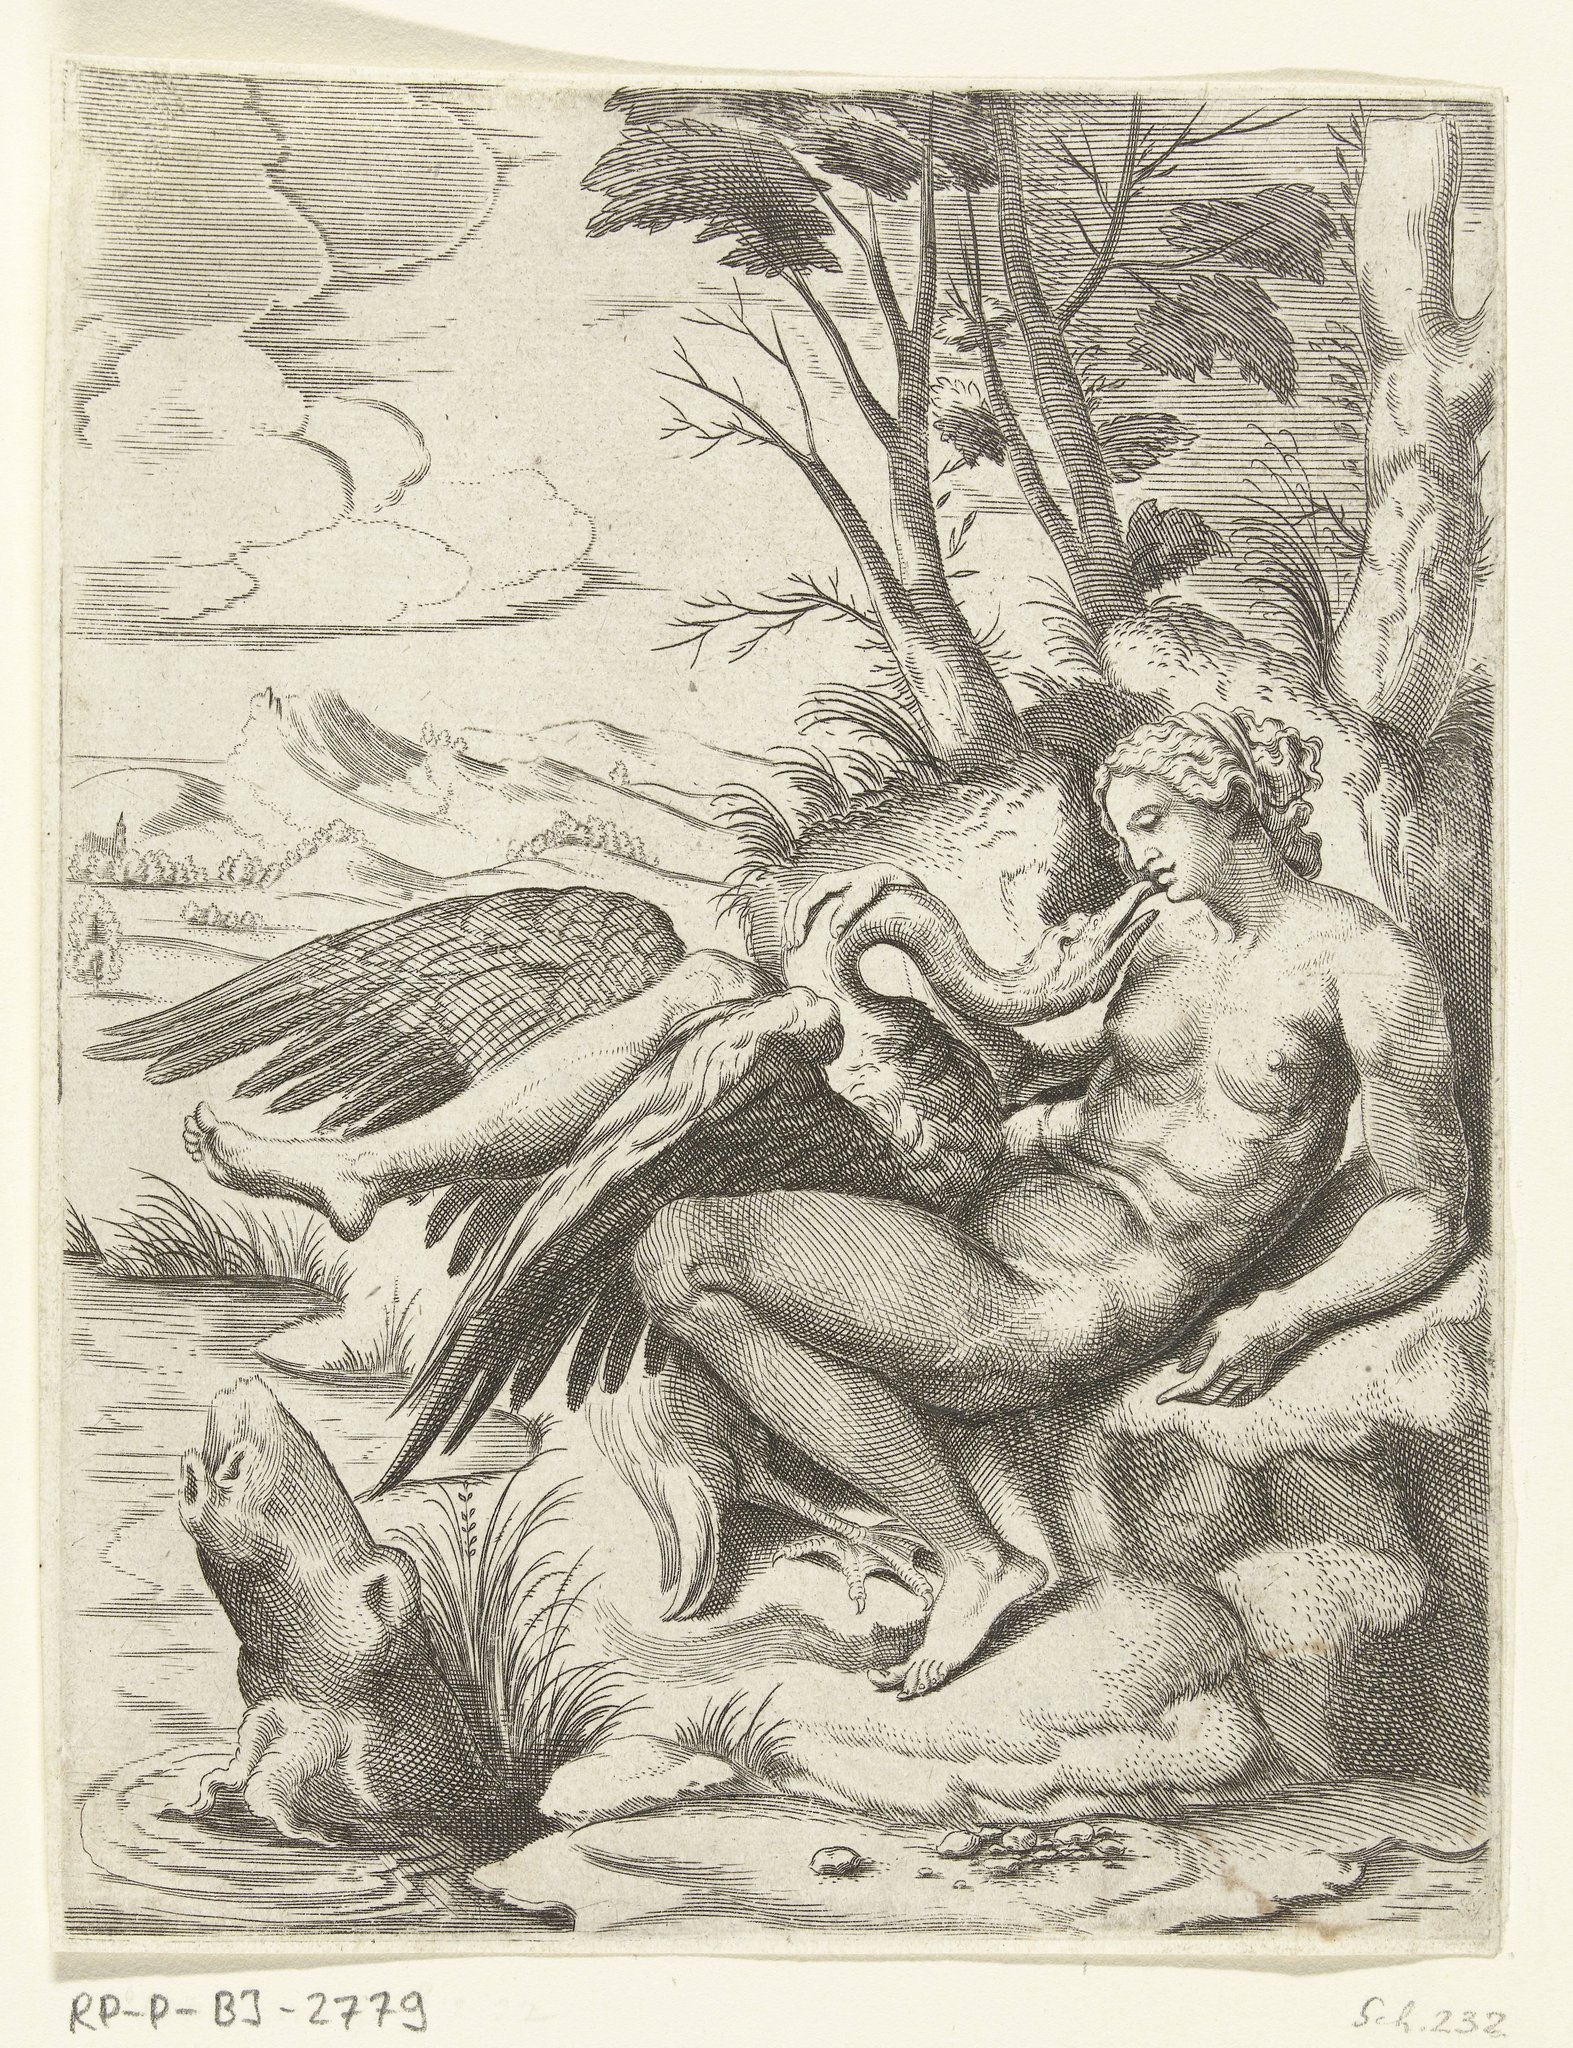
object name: print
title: Jupiters liefdesavonturen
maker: cornelis bos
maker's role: print maker, printer, publisher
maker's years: 1510-1566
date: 1537-1555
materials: paper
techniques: engraving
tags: jupiter, in the shape of a swan, and leda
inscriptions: collector's mark: Lugt 240, collector's mark: Lugt 2228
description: Jupiter verleidt Leda in de gedaante van een zwaan. Leda zit aan de oever van een water met de zwaan tussen haar benen. Prent uit een serie van 10 prenten die het liefdesleven van Jupiter illustreren.